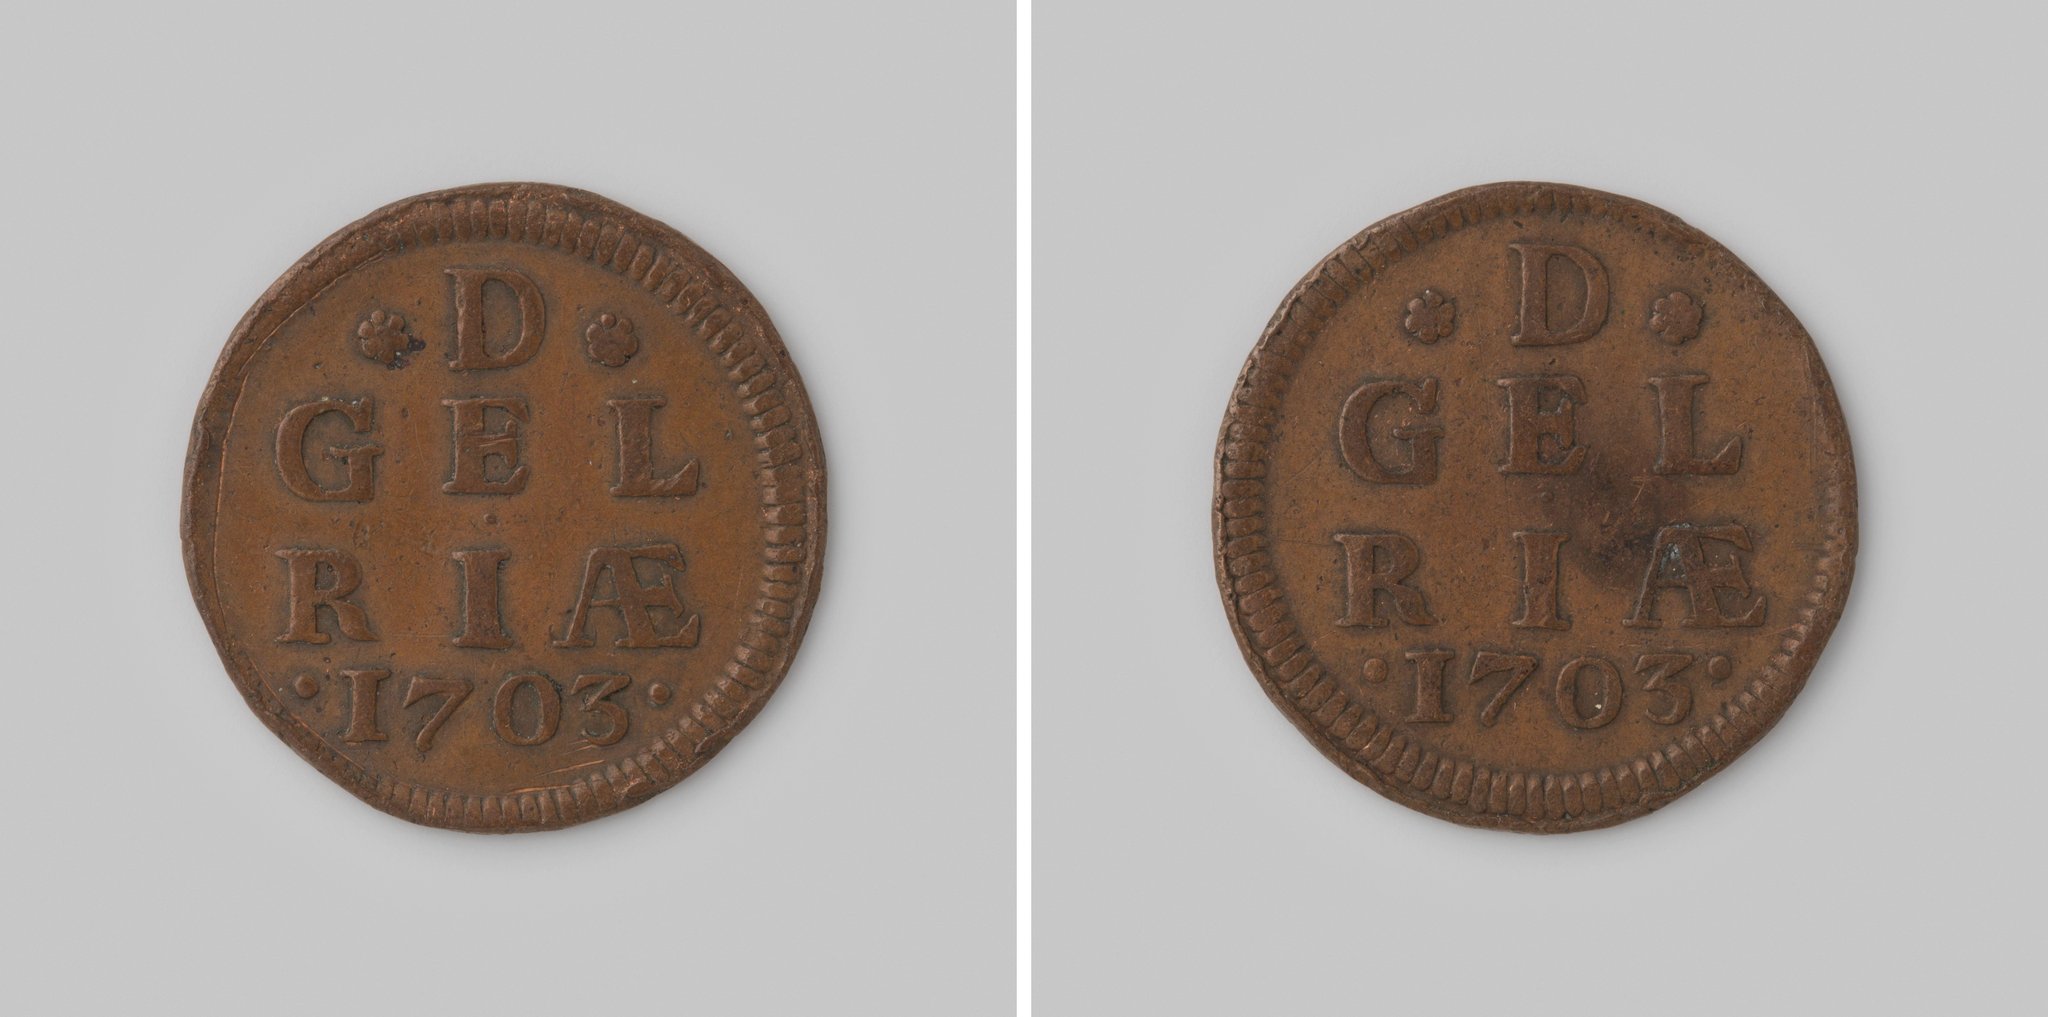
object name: coin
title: Gelderse duit, 1703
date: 1703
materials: copper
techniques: striking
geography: harderwijk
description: Koperen munt. Voorzijde: in drie regels D/GEL/RIAE, daaronder jaartal. Keerzijde: in drie regels D/GEL/RIAE.